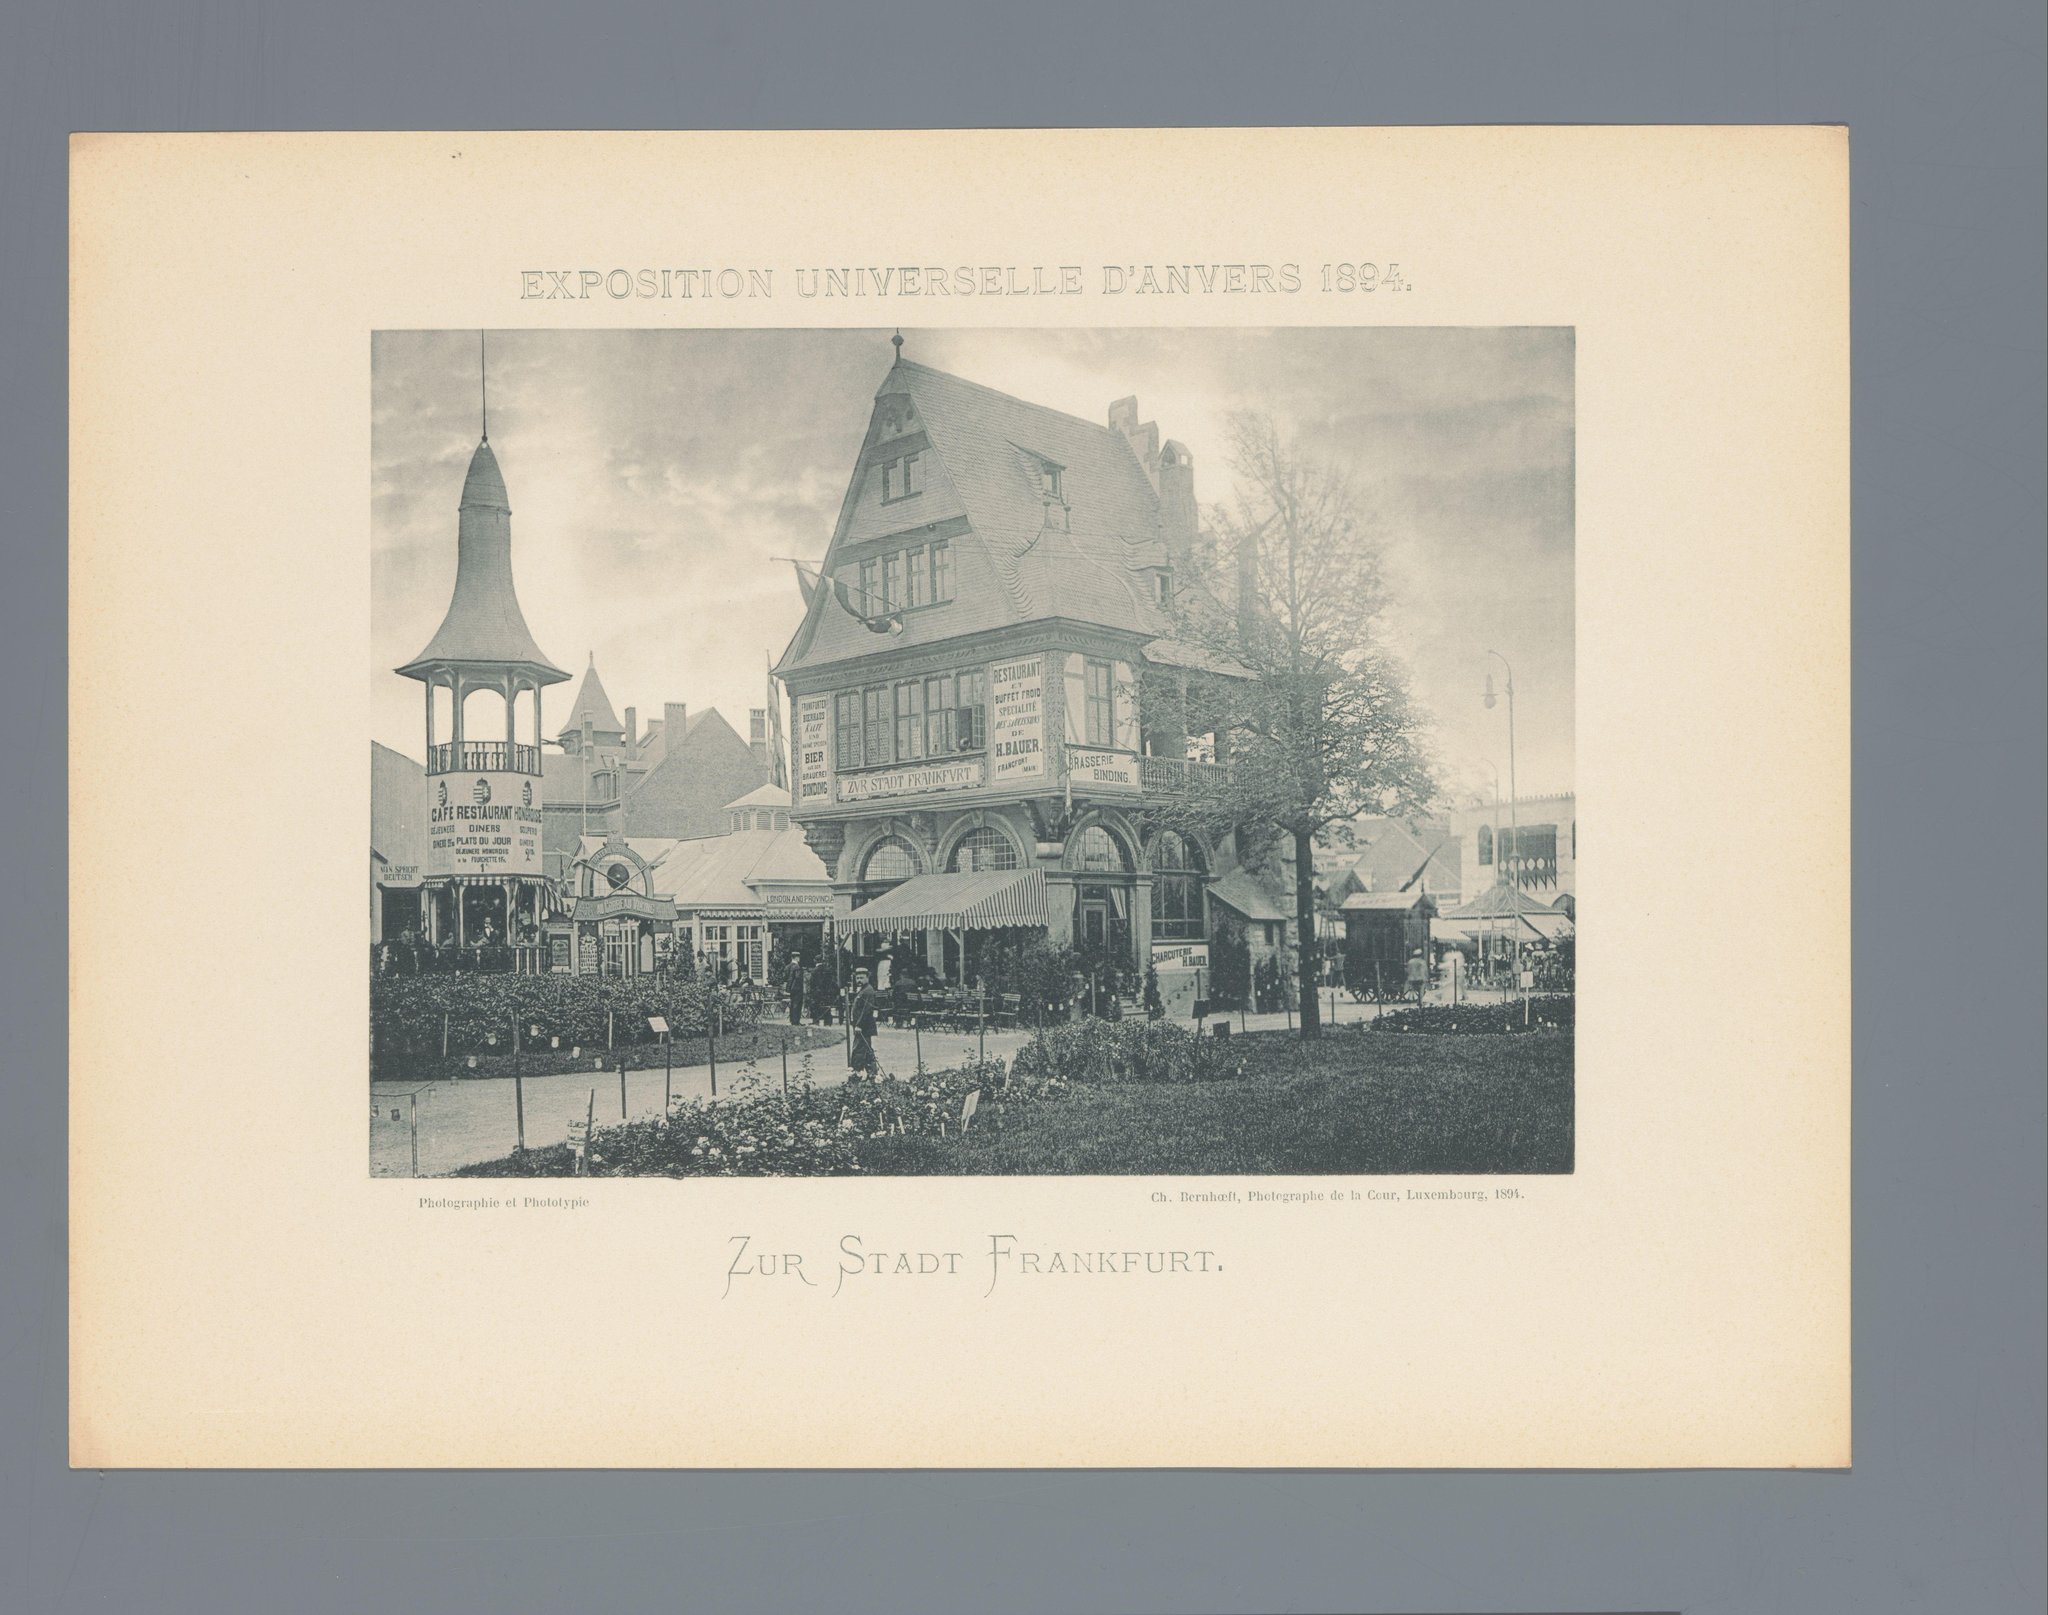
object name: photomechanical print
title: Zur stadt Frankfurt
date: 1894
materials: paper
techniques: photograph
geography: luxembourg city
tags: world fair, world exhibition, civic architecture; edifices; dwellings, antwerp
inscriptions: inscription: ‘Exposition Universelle D'Anvers 1894’